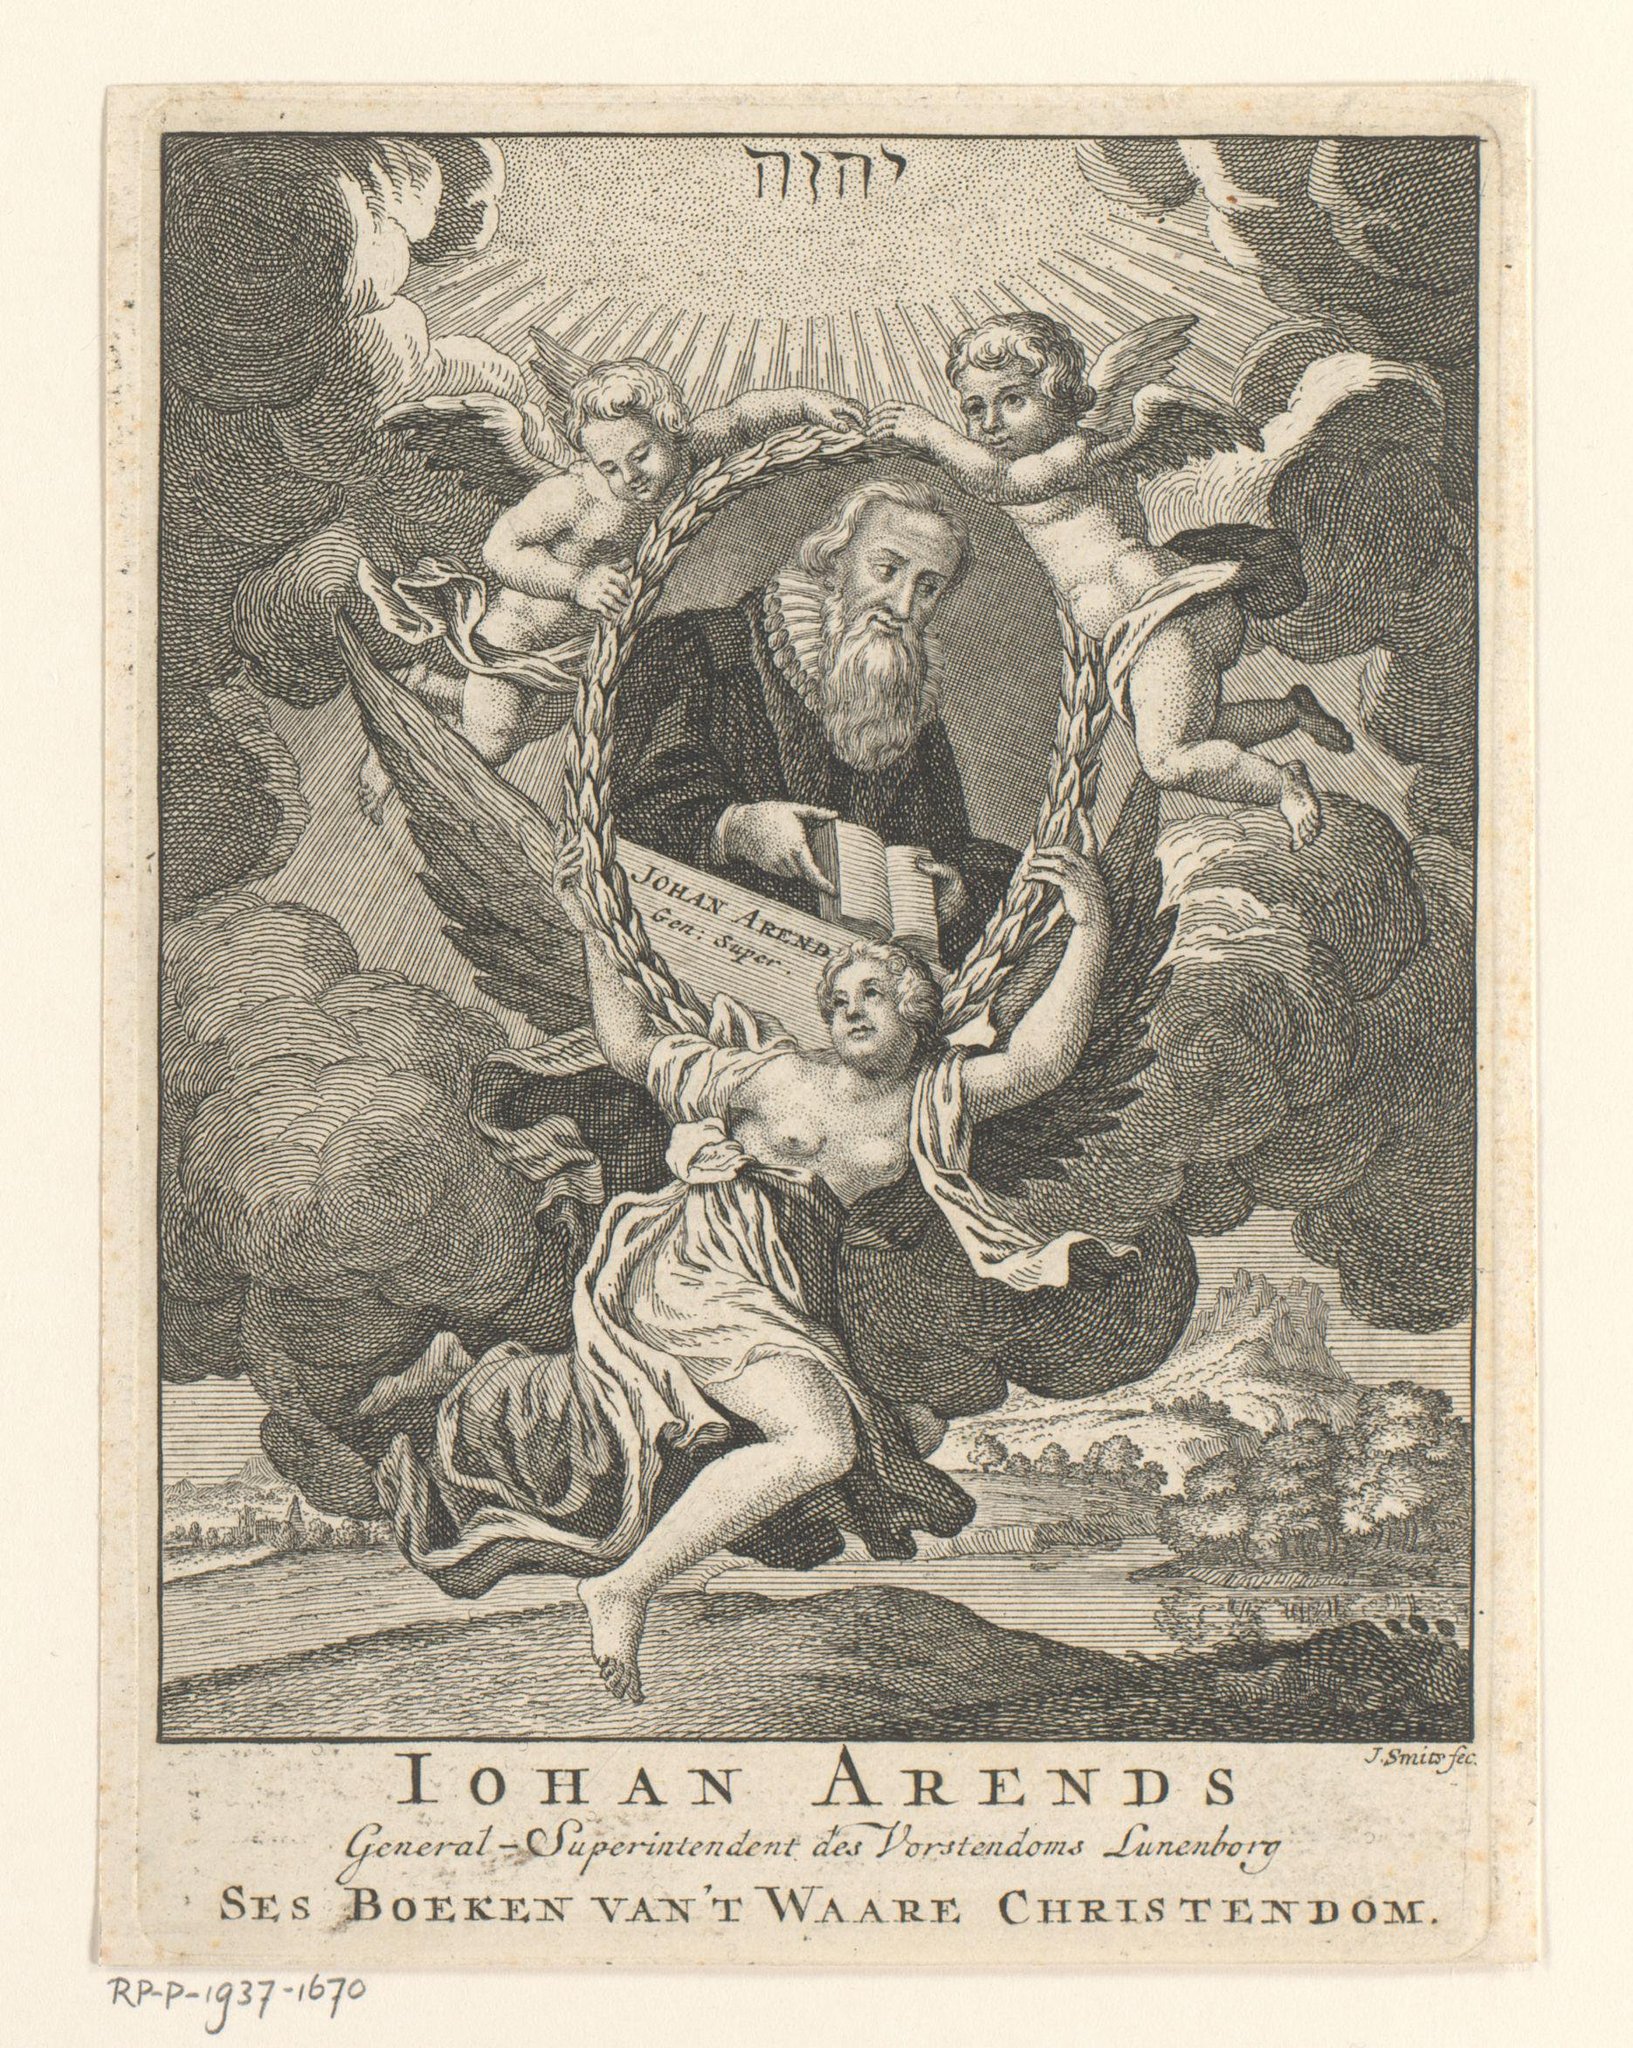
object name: titelblad, titelpagina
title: Portret van Johann Arndt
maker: jan smit (ii)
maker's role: print maker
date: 1741-1748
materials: paper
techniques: engraving, etching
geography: amsterdam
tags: tetragram (in roman or hebrew script) ~ symbol of god the father, cupids: 'amores', 'amoretti', 'putti'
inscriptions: collector's mark: Lugt 2760, collector's mark: Lugt 2228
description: Een engel en twee putti houden het met een lauwerskrans omgeven portret van de Duitse theoloog Johann Arndt omhoog. Daarboven in een stralenkrans het Tetragram. Onder de afbeelding de titel en de auteur van het boek.